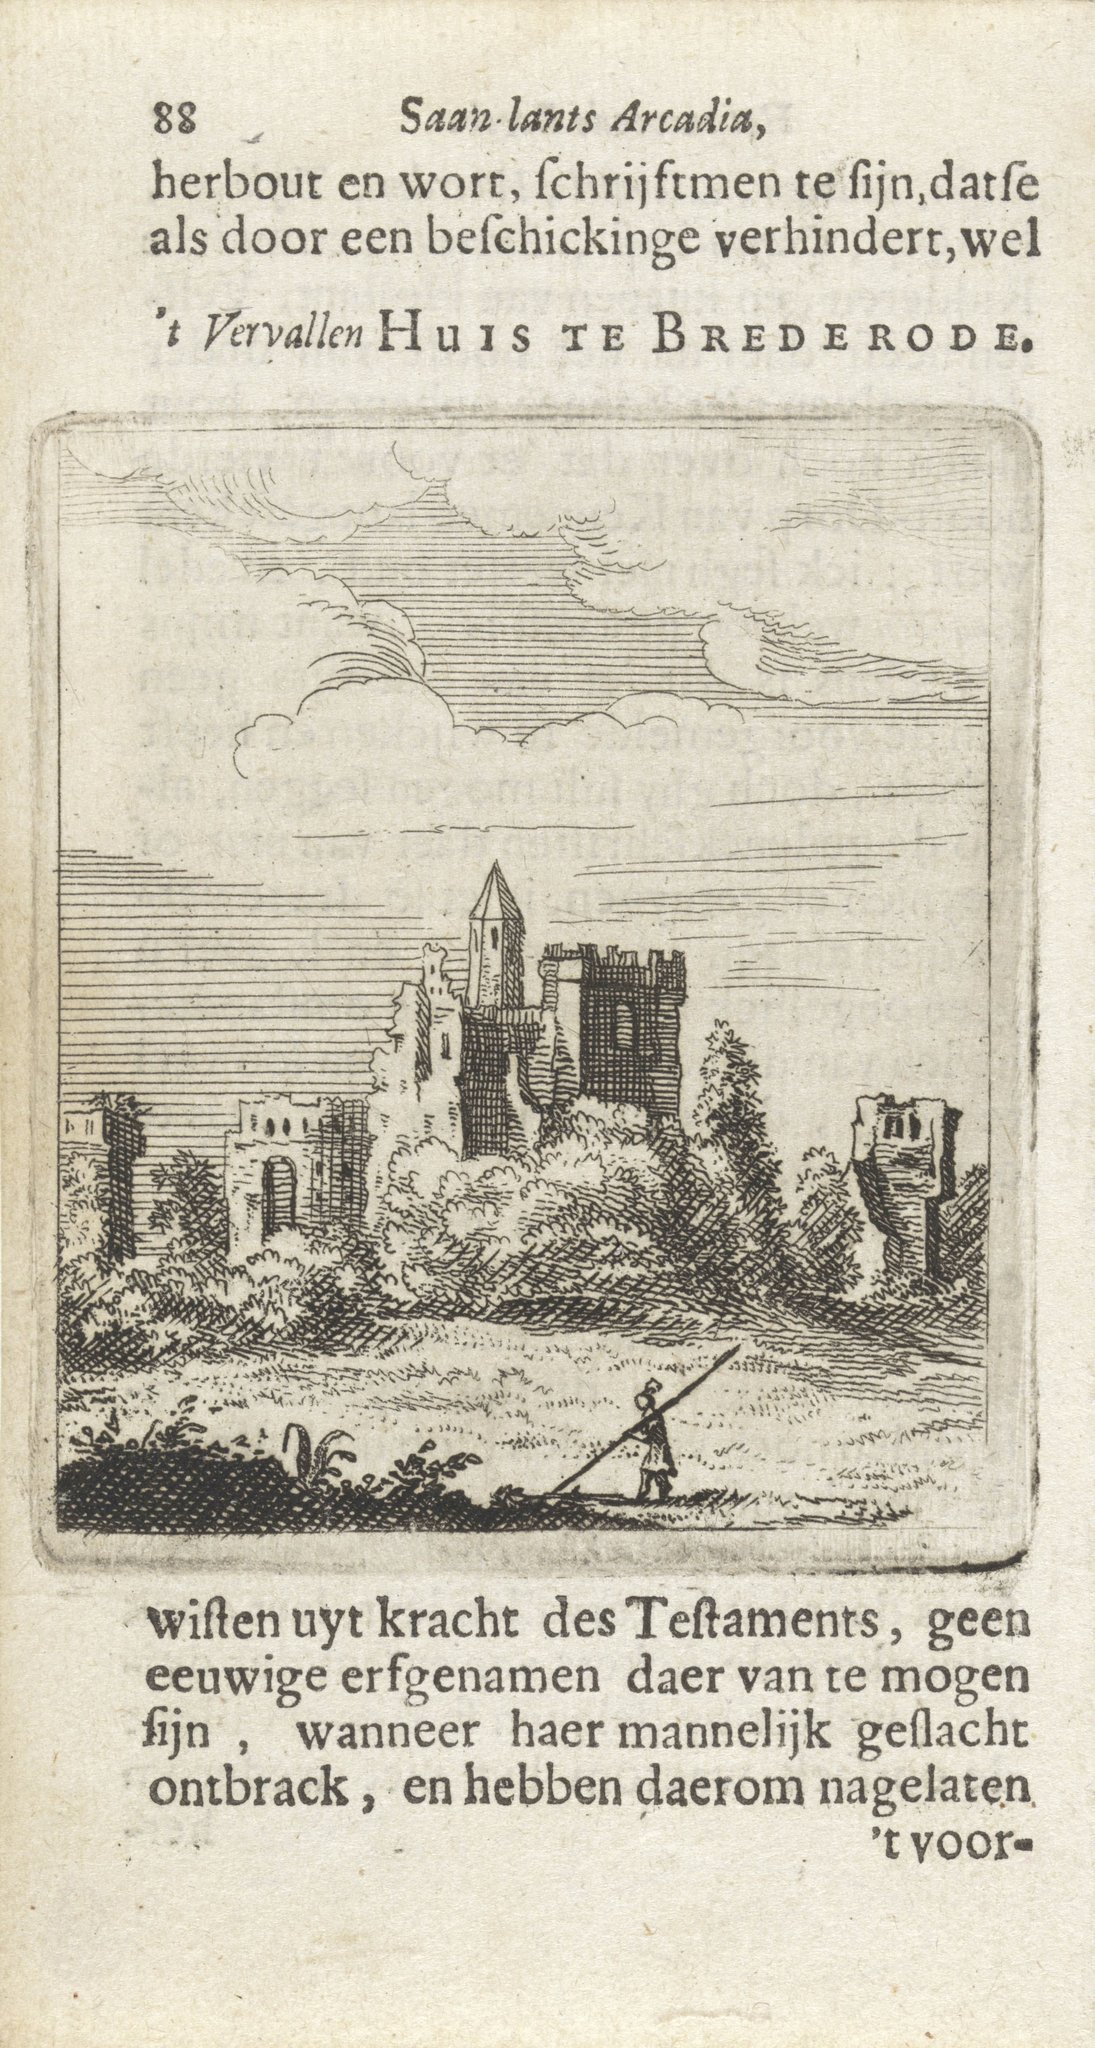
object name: print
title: 't Vervallen huis te Brederode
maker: hendrik jacobsz soeteboom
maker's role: print maker, publisher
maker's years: 1616-1678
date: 1658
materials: paper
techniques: engraving, etching, letterpress printing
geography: zaandam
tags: ruin of a dwelling, house, castle, etc.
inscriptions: collector's mark: Lugt 2228, collector's mark: Lugt 2760, collector's mark: Lugt 2228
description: Gebruikt als illustratie op p. 88 van: Hendrik Jacobsz Soeteboom. De Zaanlants Arkadia. Amsterdam: Gerrit van Goedesberg, 1658.